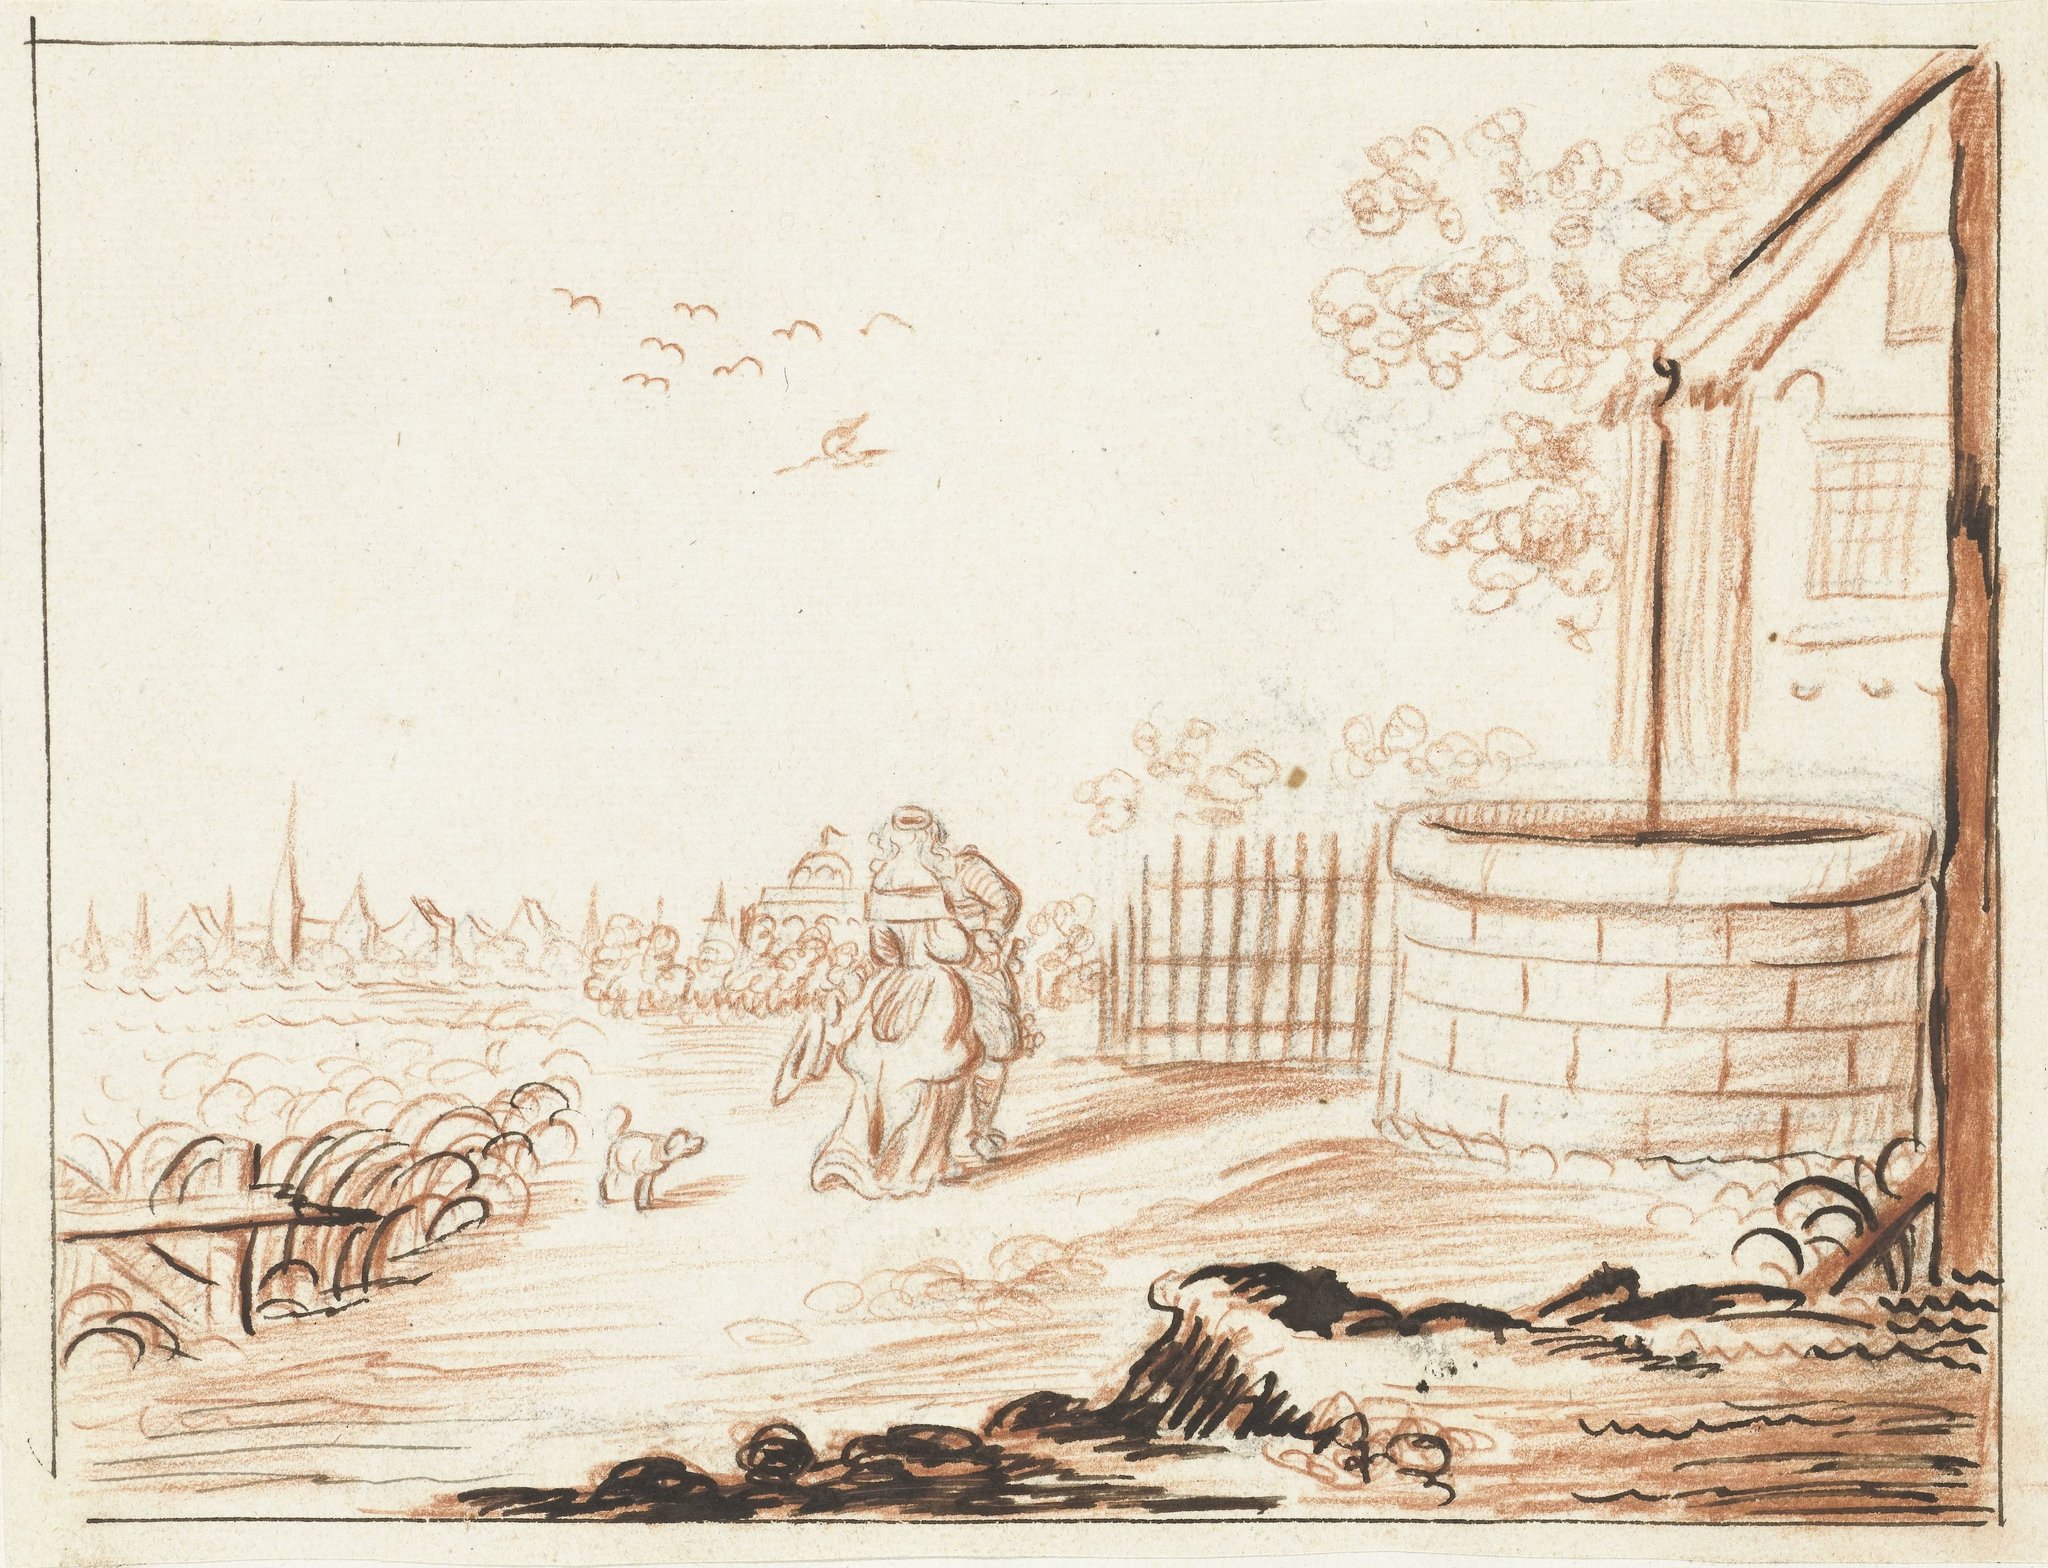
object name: drawing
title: Heer en dame elkaar begroetend voor een landhuis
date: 1643-1687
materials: chalk, ink, paper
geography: zwolle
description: Tekening naast twee andere tekeningen in het Familie-plakboek geplakt. Gemaakt door Gesina en/of Harmen ter Borch.